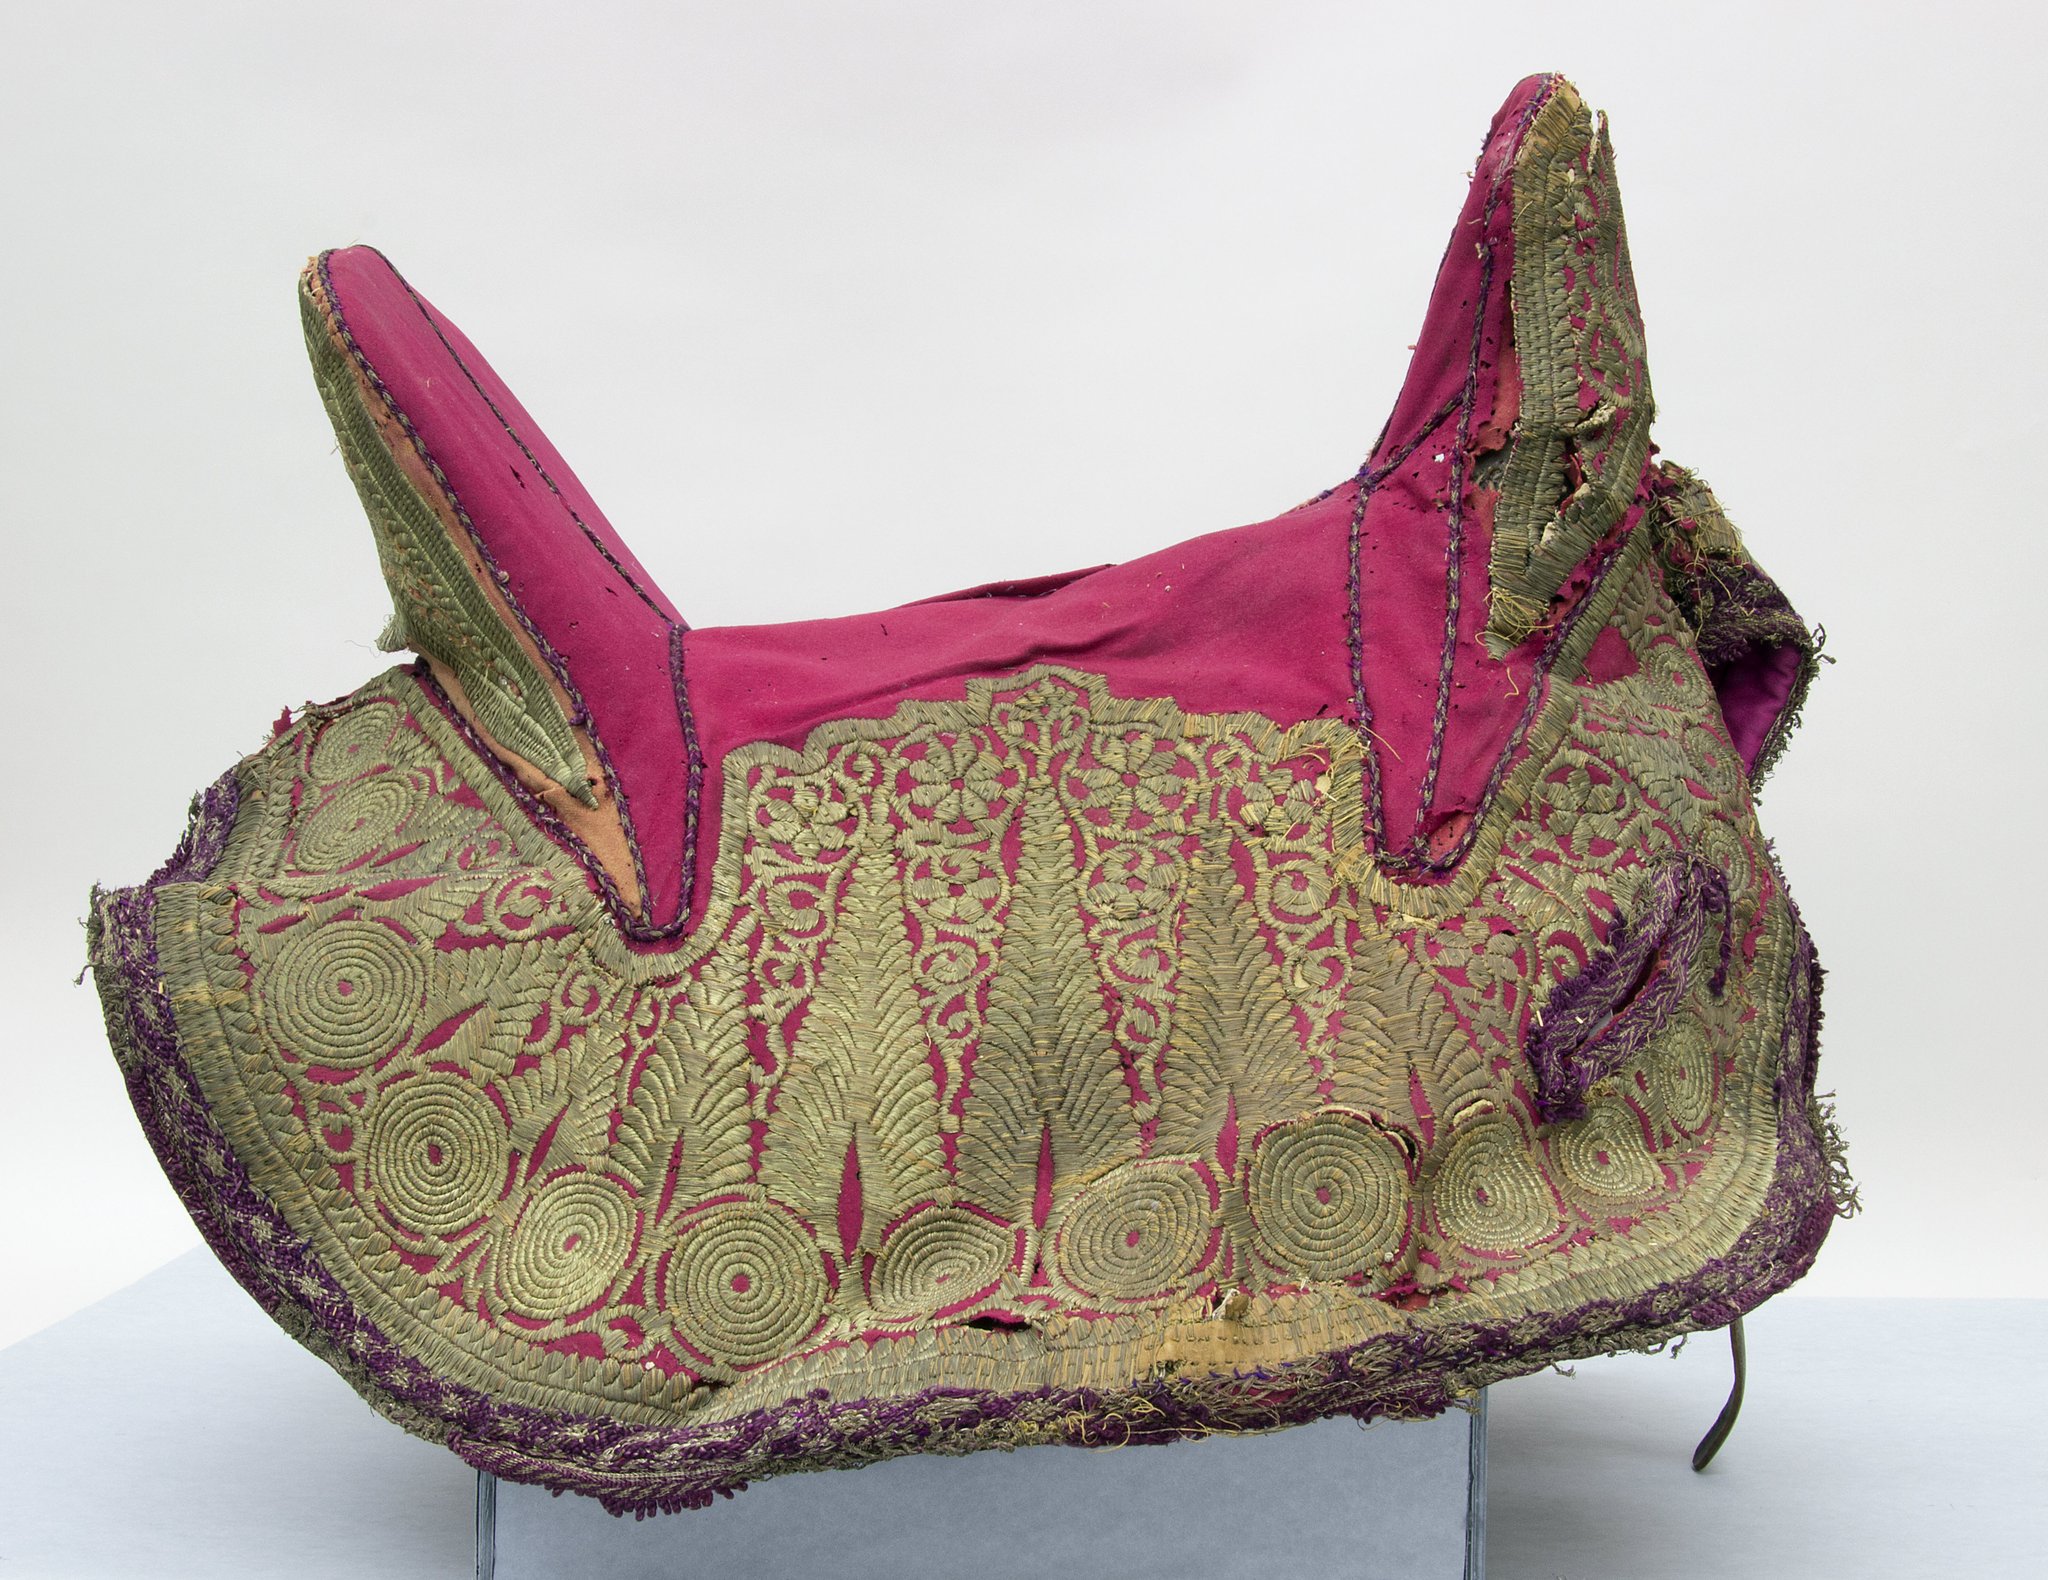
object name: saddle, bridle, bit, and trapping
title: Saddle, Bridle, Bit, and Trappings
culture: moroccan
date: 1701-1900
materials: gold, iron, leather, metal thread, textile, tin, wood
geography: morocco